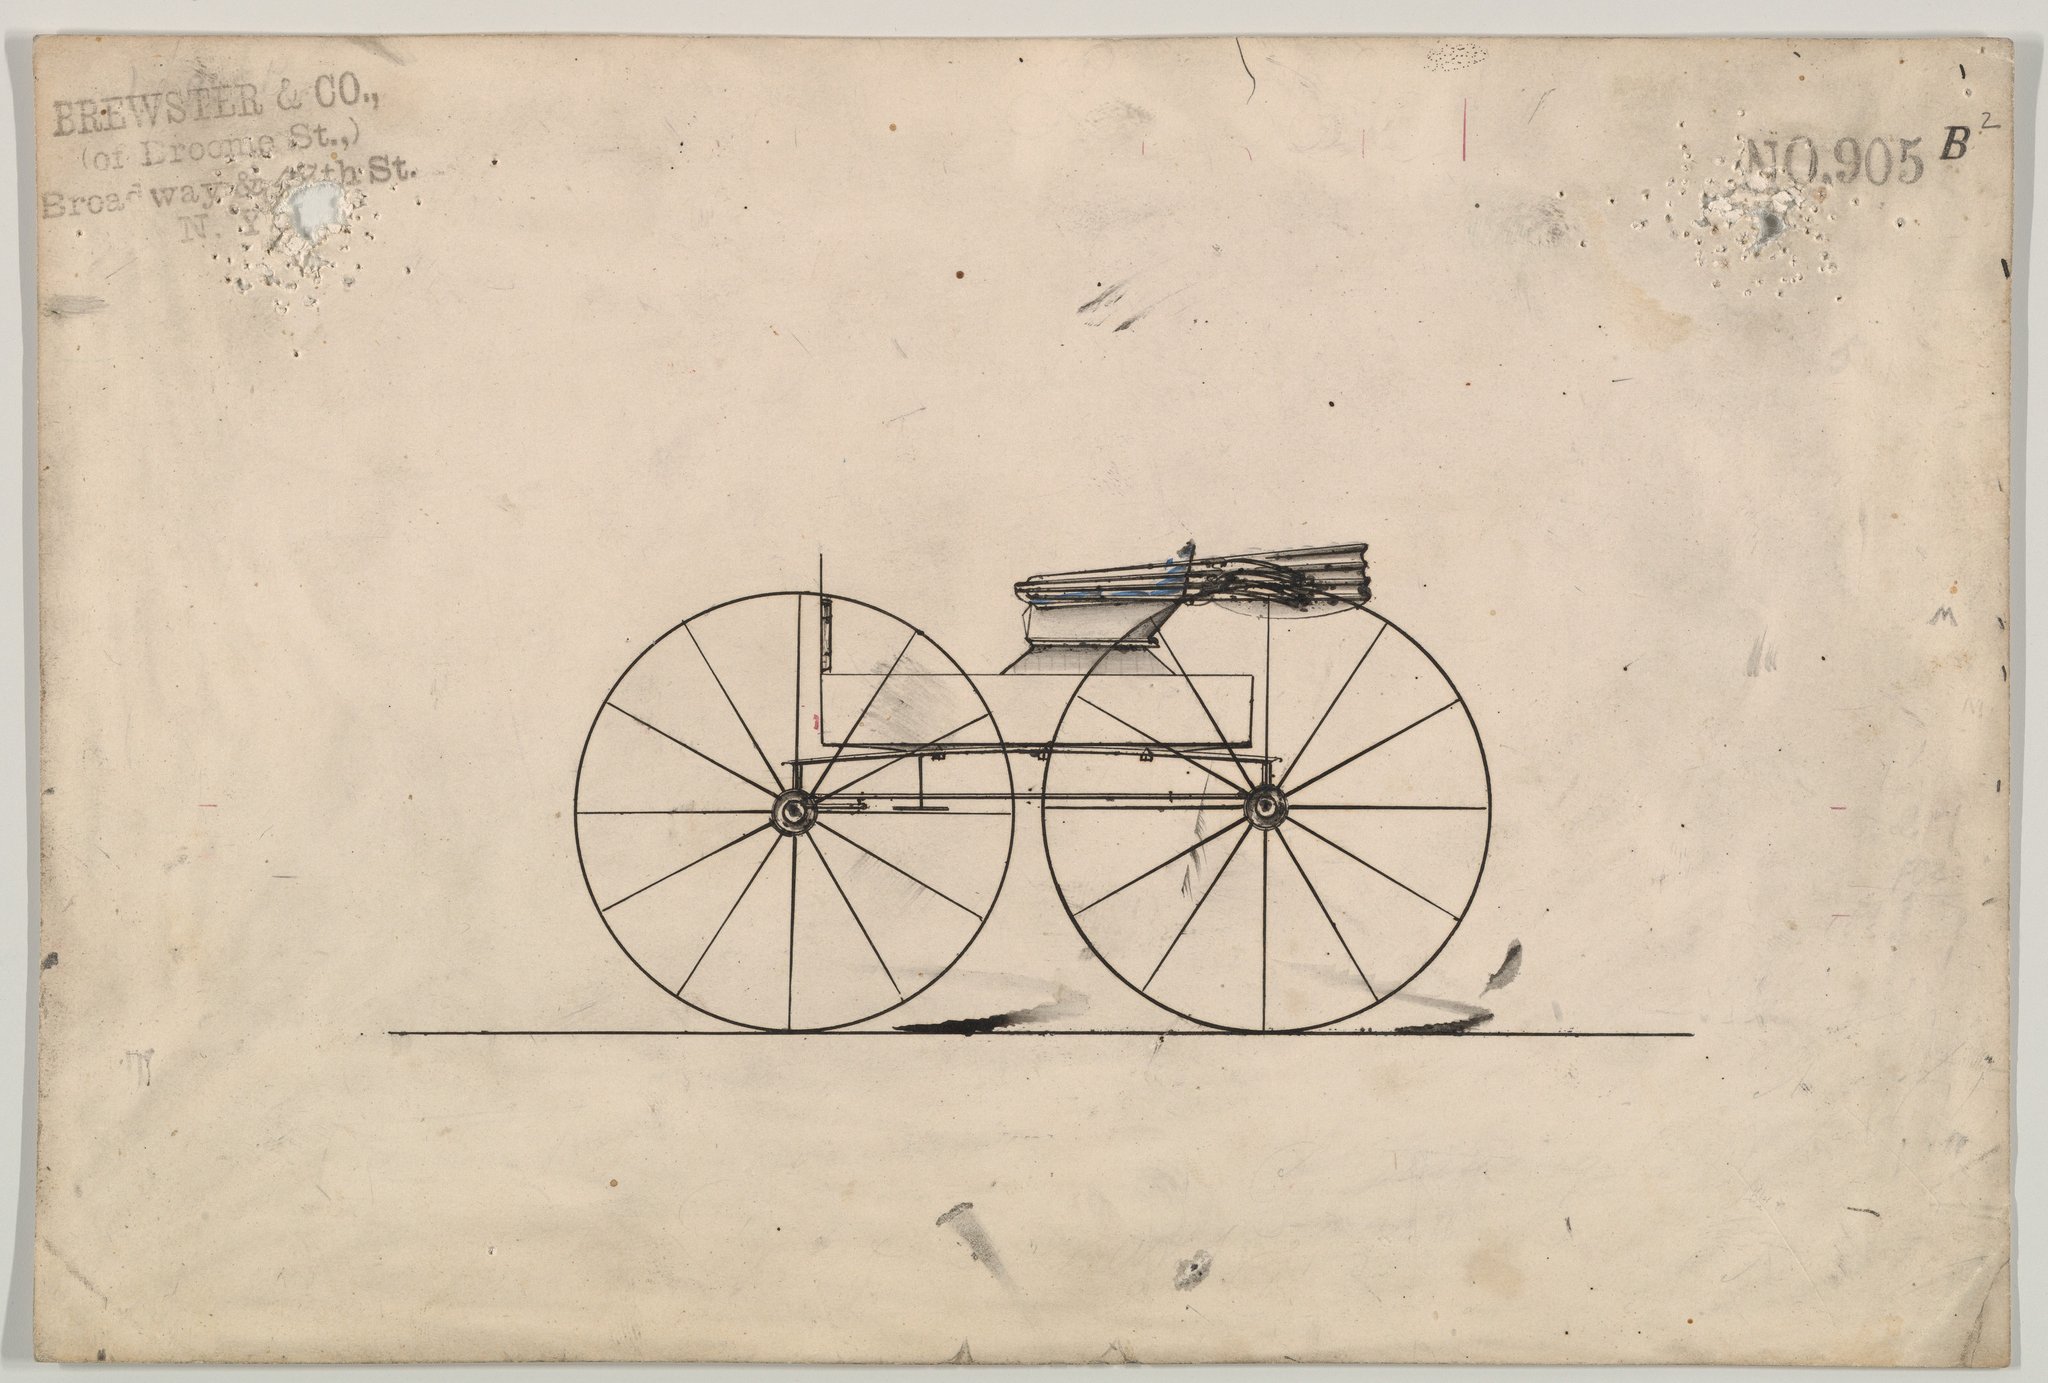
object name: drawing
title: Design for Wagon, no. 905b-2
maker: brewster & co.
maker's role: manufacturer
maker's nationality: american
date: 1870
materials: gouache, ink, watercolor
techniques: pen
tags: carriages